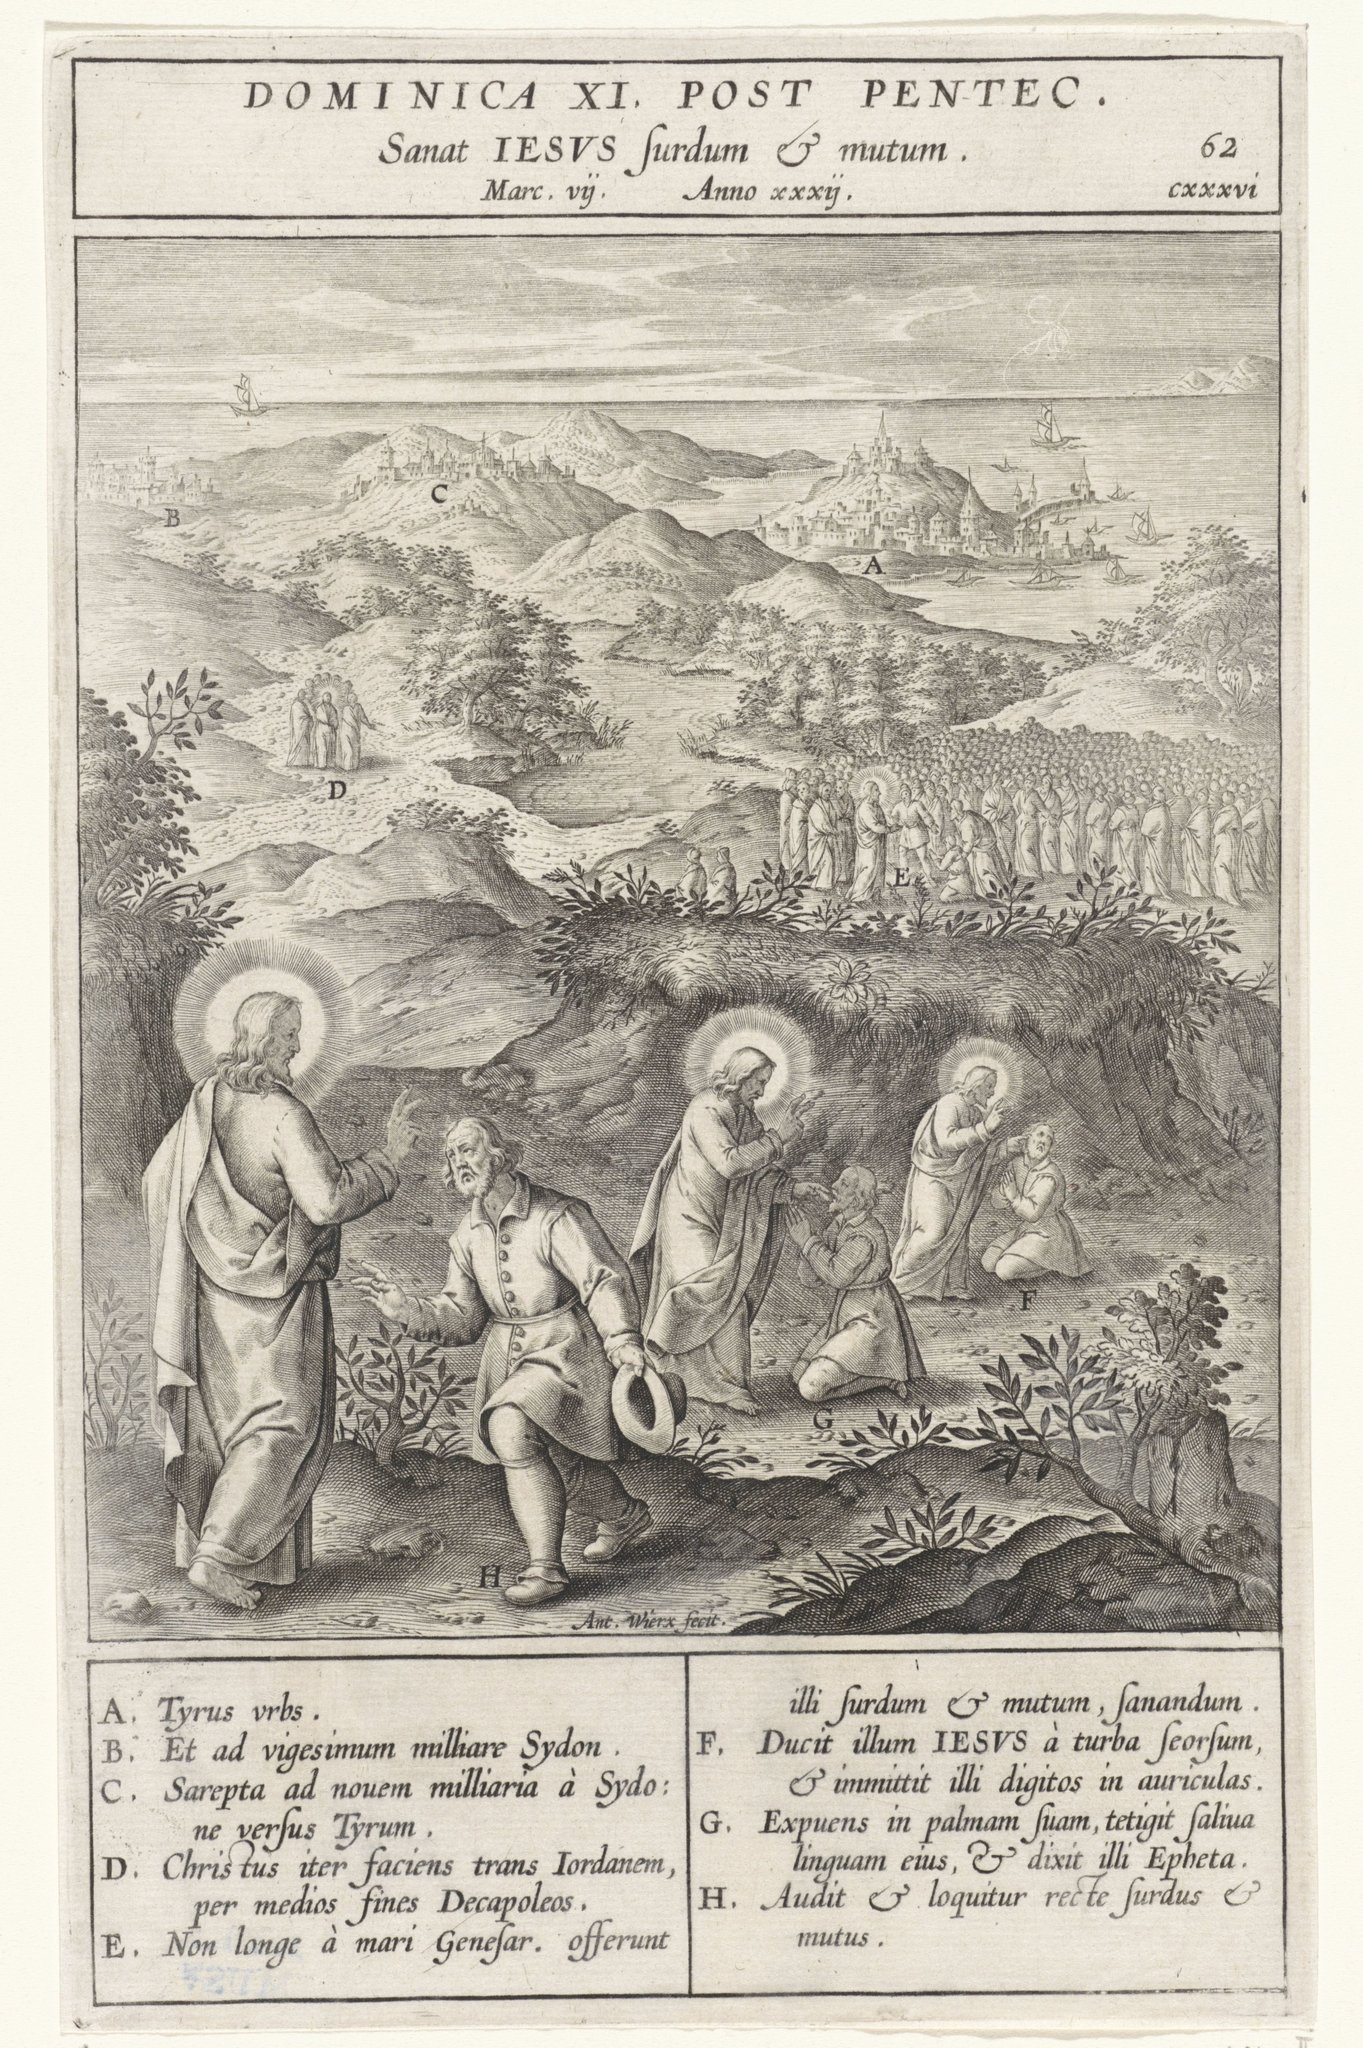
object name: print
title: Dominica XI. Post Pentec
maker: antonie wierix (ii)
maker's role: draughtsman, print maker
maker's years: 1555-1604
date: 1593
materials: paper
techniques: engraving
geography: antwerp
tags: healing of a deaf man in decapolis (mark 7:31-37), deaf, deafness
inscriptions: collector's mark: Lugt 2165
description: Christus reist door het gebied van Dekapolis. Daar wordt een man bij hem gebracht die doof is en gebrekkig spreekt. Hij neemt de man apart, weg van de menigte, steekt zijn vingers in diens oren en raakt met speeksel zijn tong aan. Bij verschillende elementen uit de voorstelling staan letters die corresponderen met de legenda in de marge. Voorstelling van een Bijbelverhaal over de genezing in Marcus 7:32. Dit is in de Statenvertaling beschreven als: “En zij brachten tot Hem een dove, die zwaarlijk sprak, en baden Hem, dat Hij de hand op hem legde.”In de Nieuwe Bijbelvertaling 21 staat: “Daar werd iemand bij Hem gebracht die doof was en gebrekkig sprak, en men smeekte Hem om deze man de hand op te leggen.”